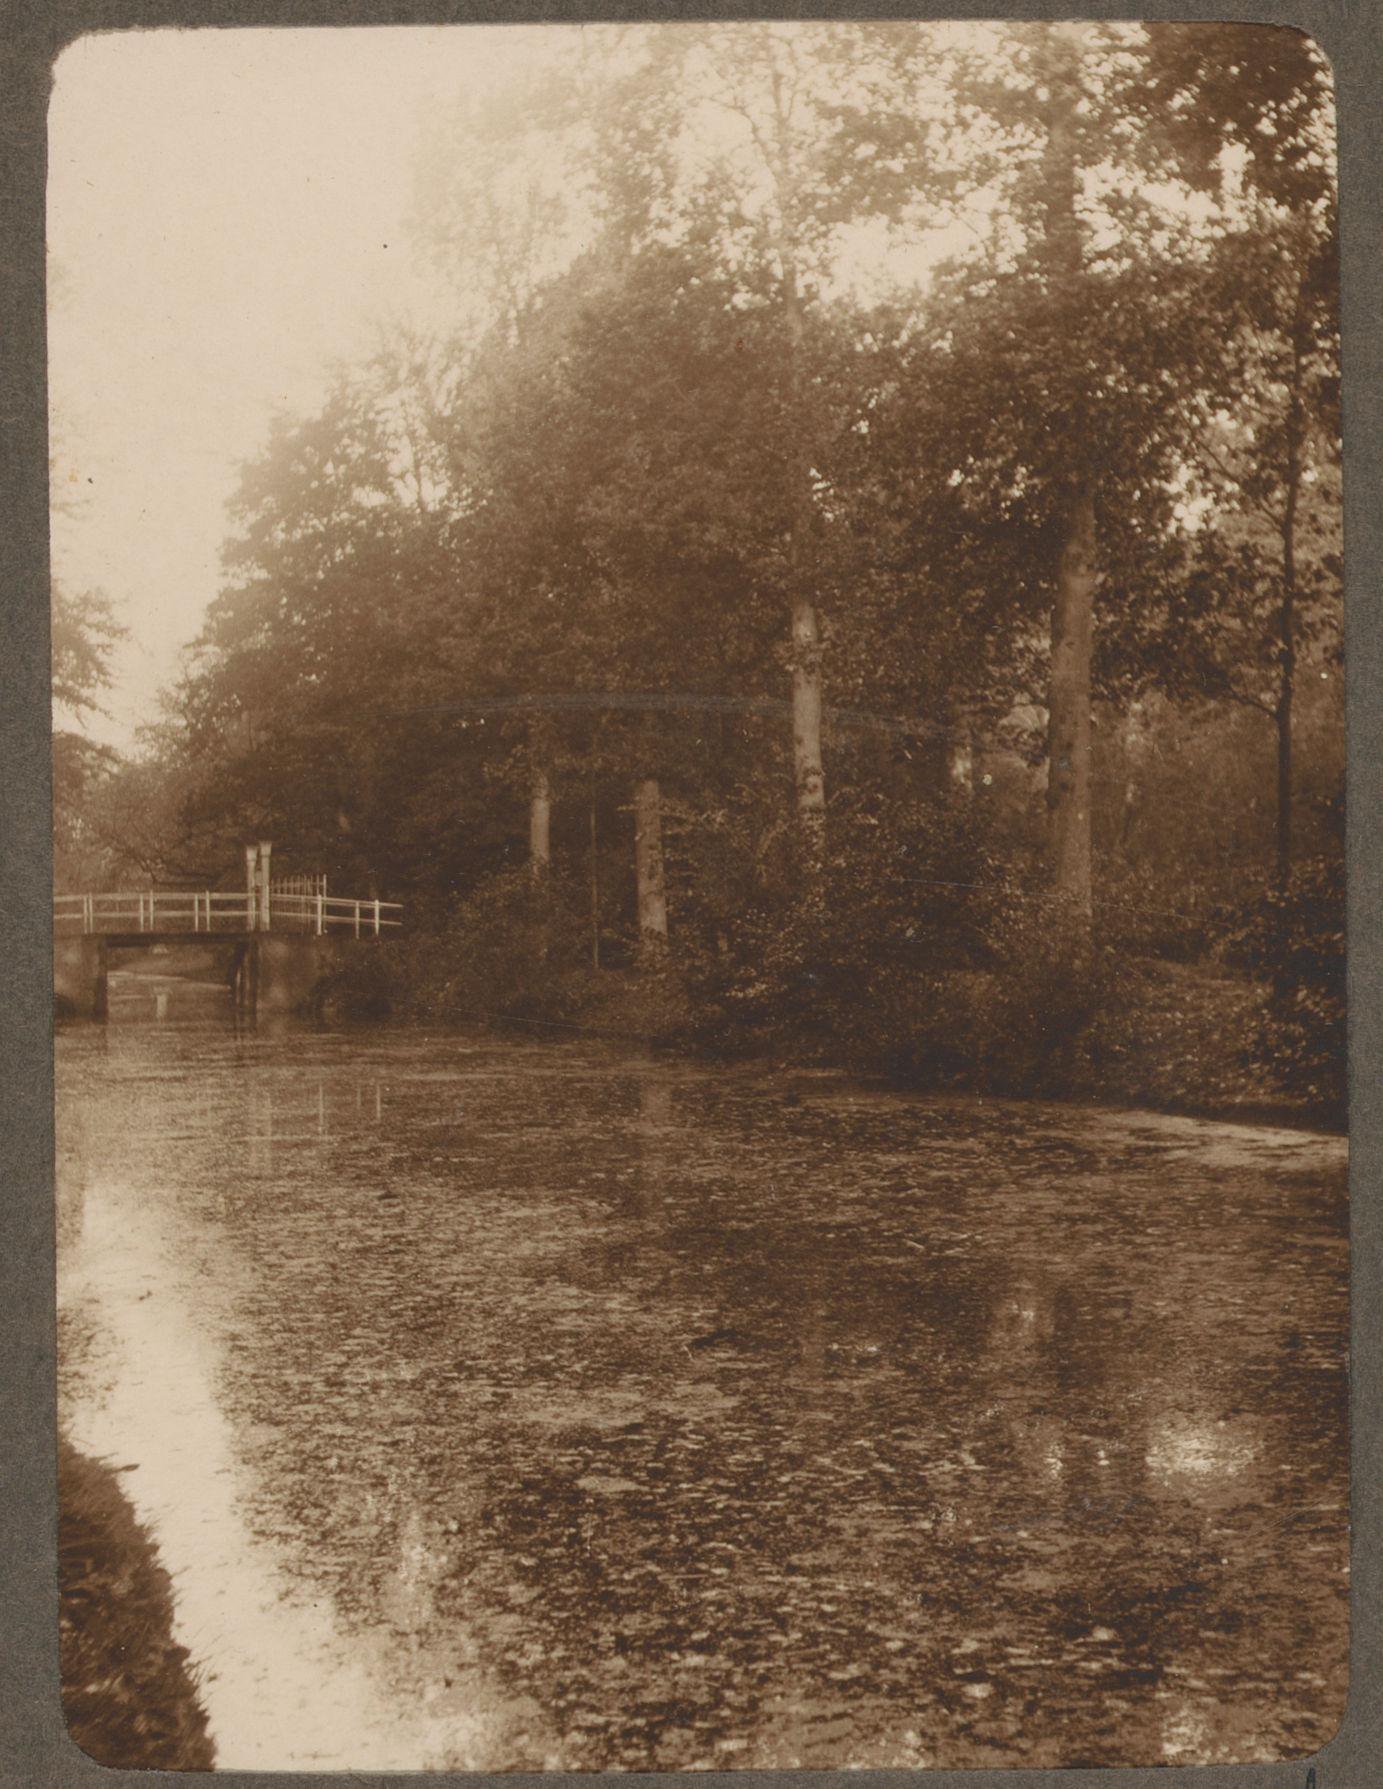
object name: album leaf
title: Landschap met bomen, een water en een brug op landgoed Fidelio te 's-Graveland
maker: Anonymous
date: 1902-1906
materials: cardboard, paper, photographic support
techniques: gelatin silver print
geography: s-graveland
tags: trees, landscapes with waters, waterscapes, seascapes (in the temperate zone), bridge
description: Onderdeel van Reisalbum van een Nederlandse familie met bezienswaardigheden in Europa, Egypte en New York.